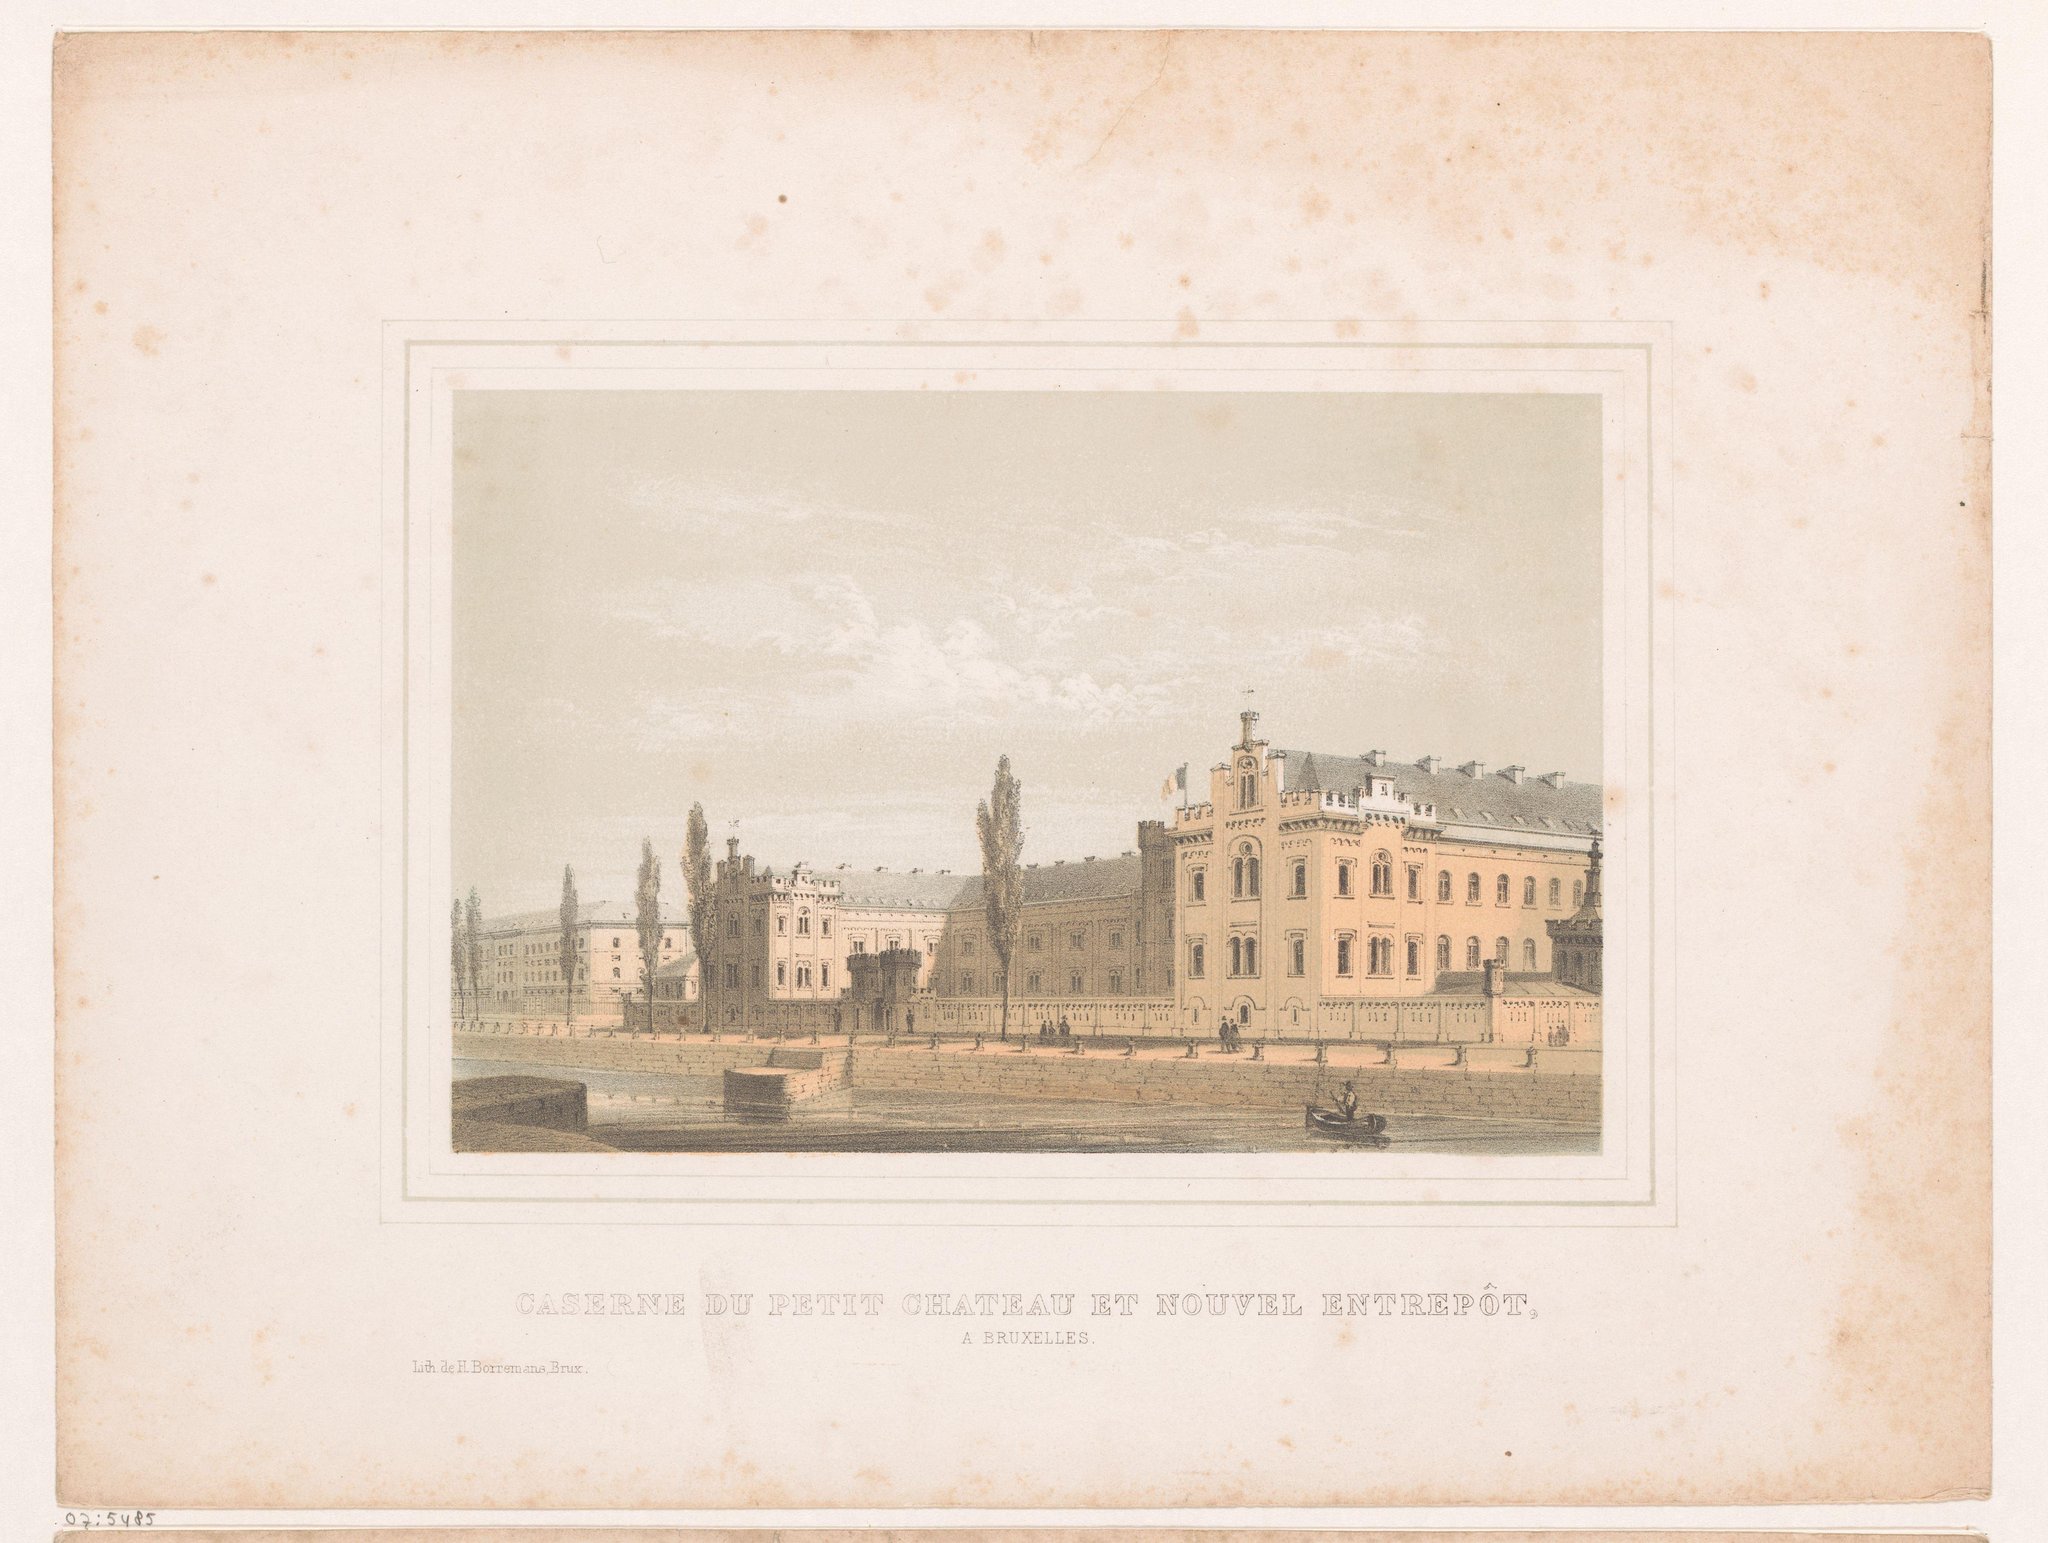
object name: print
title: Gezicht op de barakken van het Klein Kasteeltje en het nieuwe magazijn te Brussels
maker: henri borremans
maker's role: print maker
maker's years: 1800-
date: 1834-1862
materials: paper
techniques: tone lithography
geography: brussels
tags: canals, waters (in city), civic architecture; edifices; dwellings, brussels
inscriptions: collector's mark: Lugt 2228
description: Prent behoort waarschijnlijk tot een serie prenten met gezichten op Brussel en omstreken.